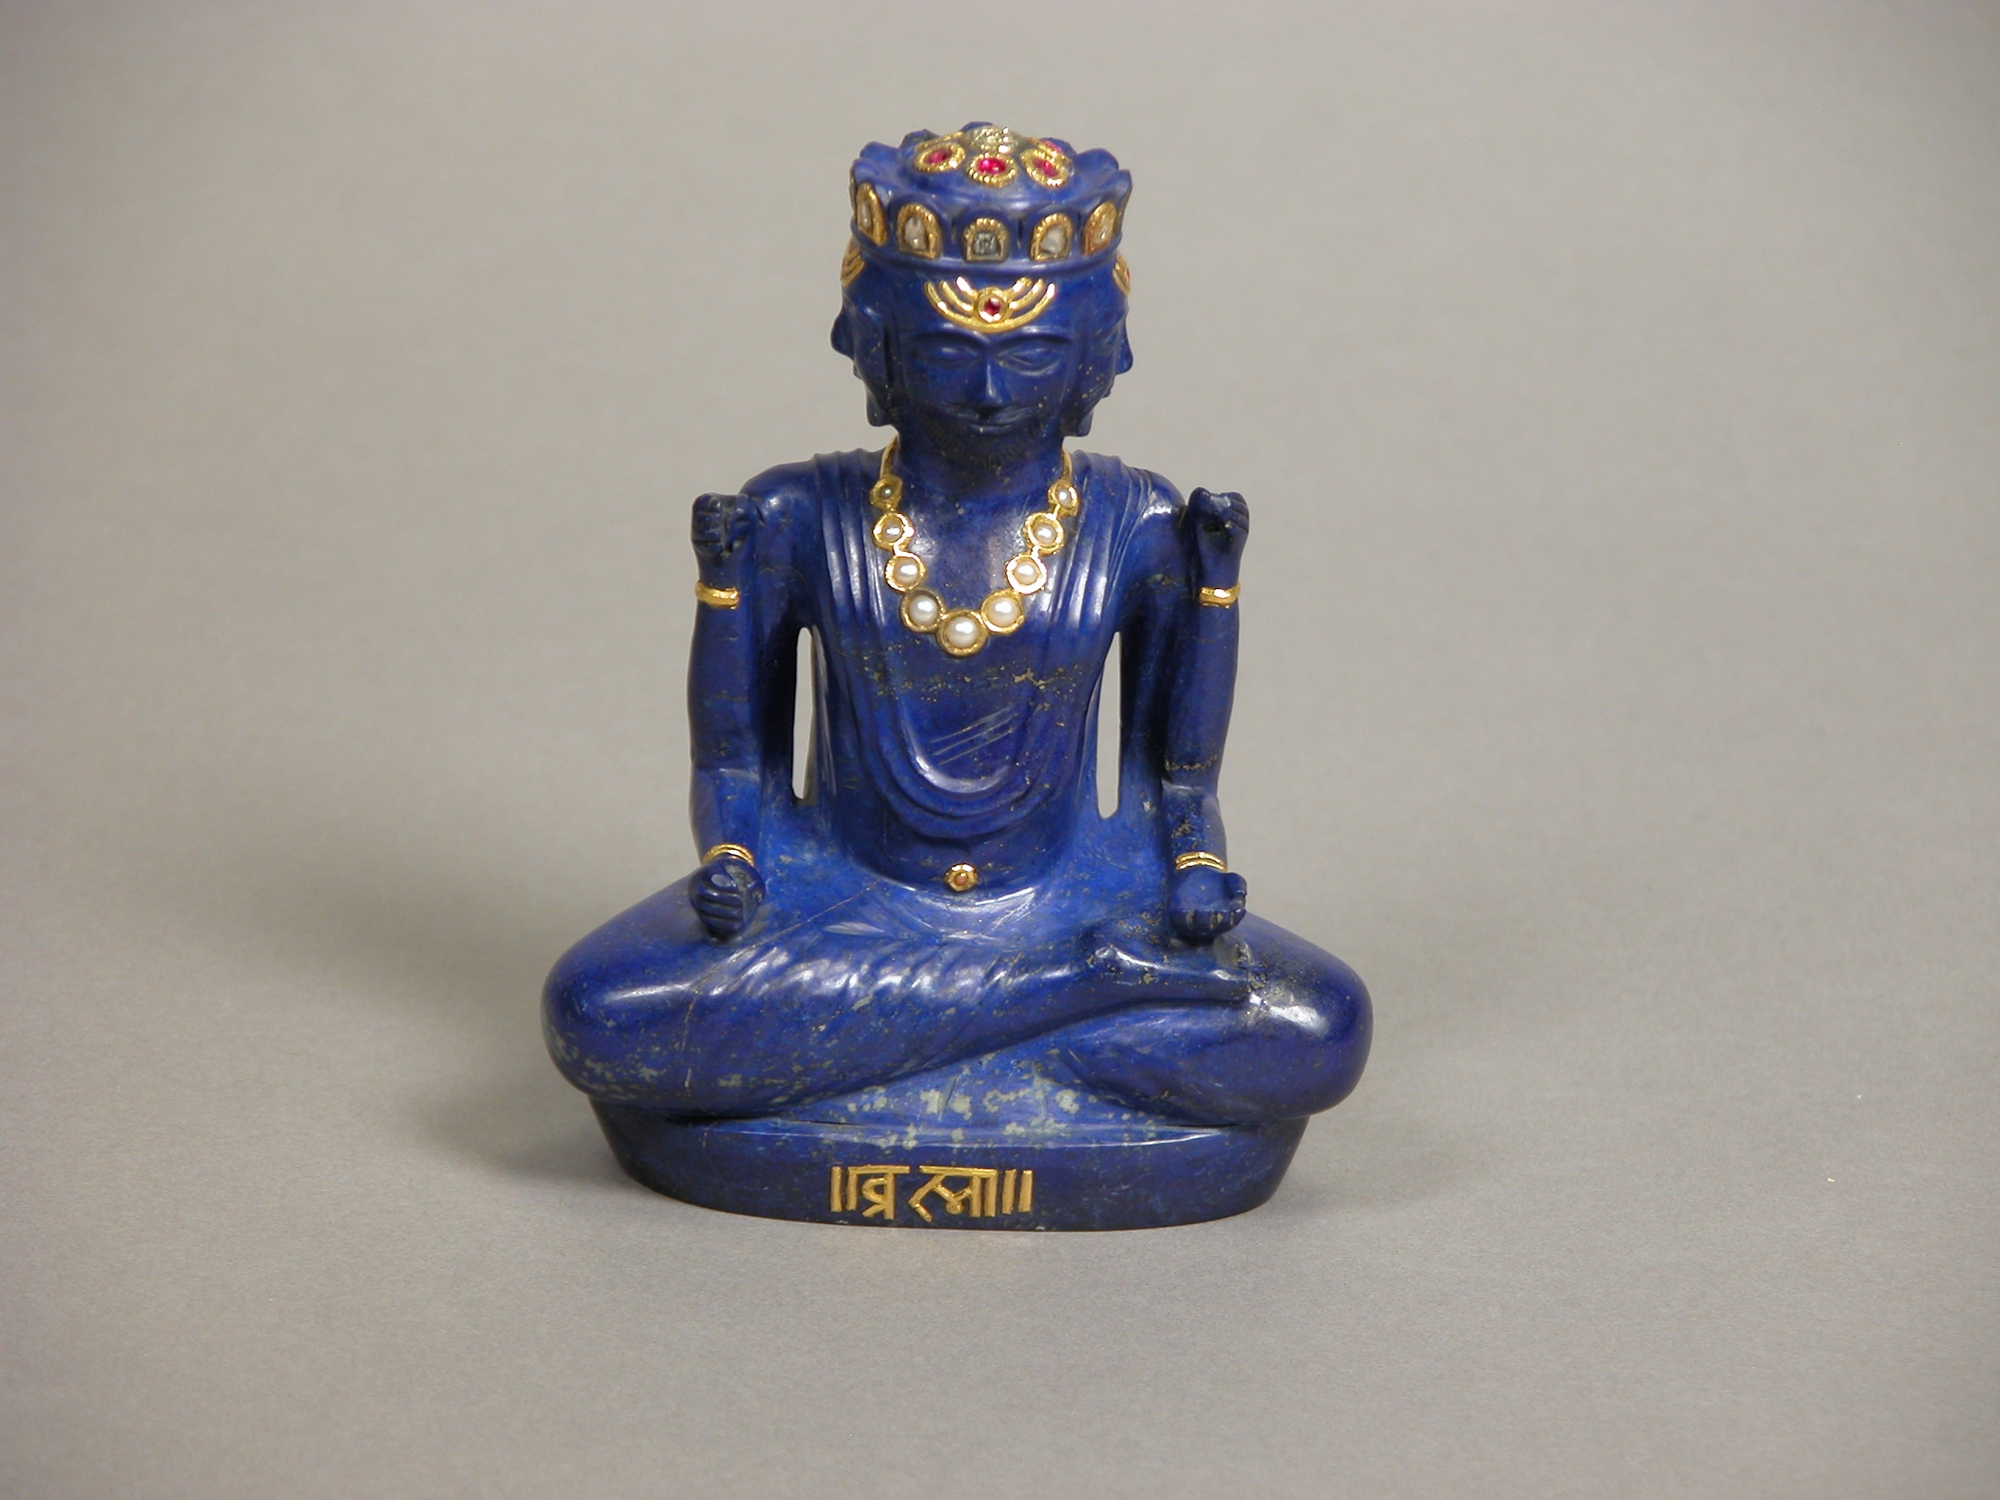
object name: figure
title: Figure of an Indian deity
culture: chinese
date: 1701-1900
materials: lapis lazuli